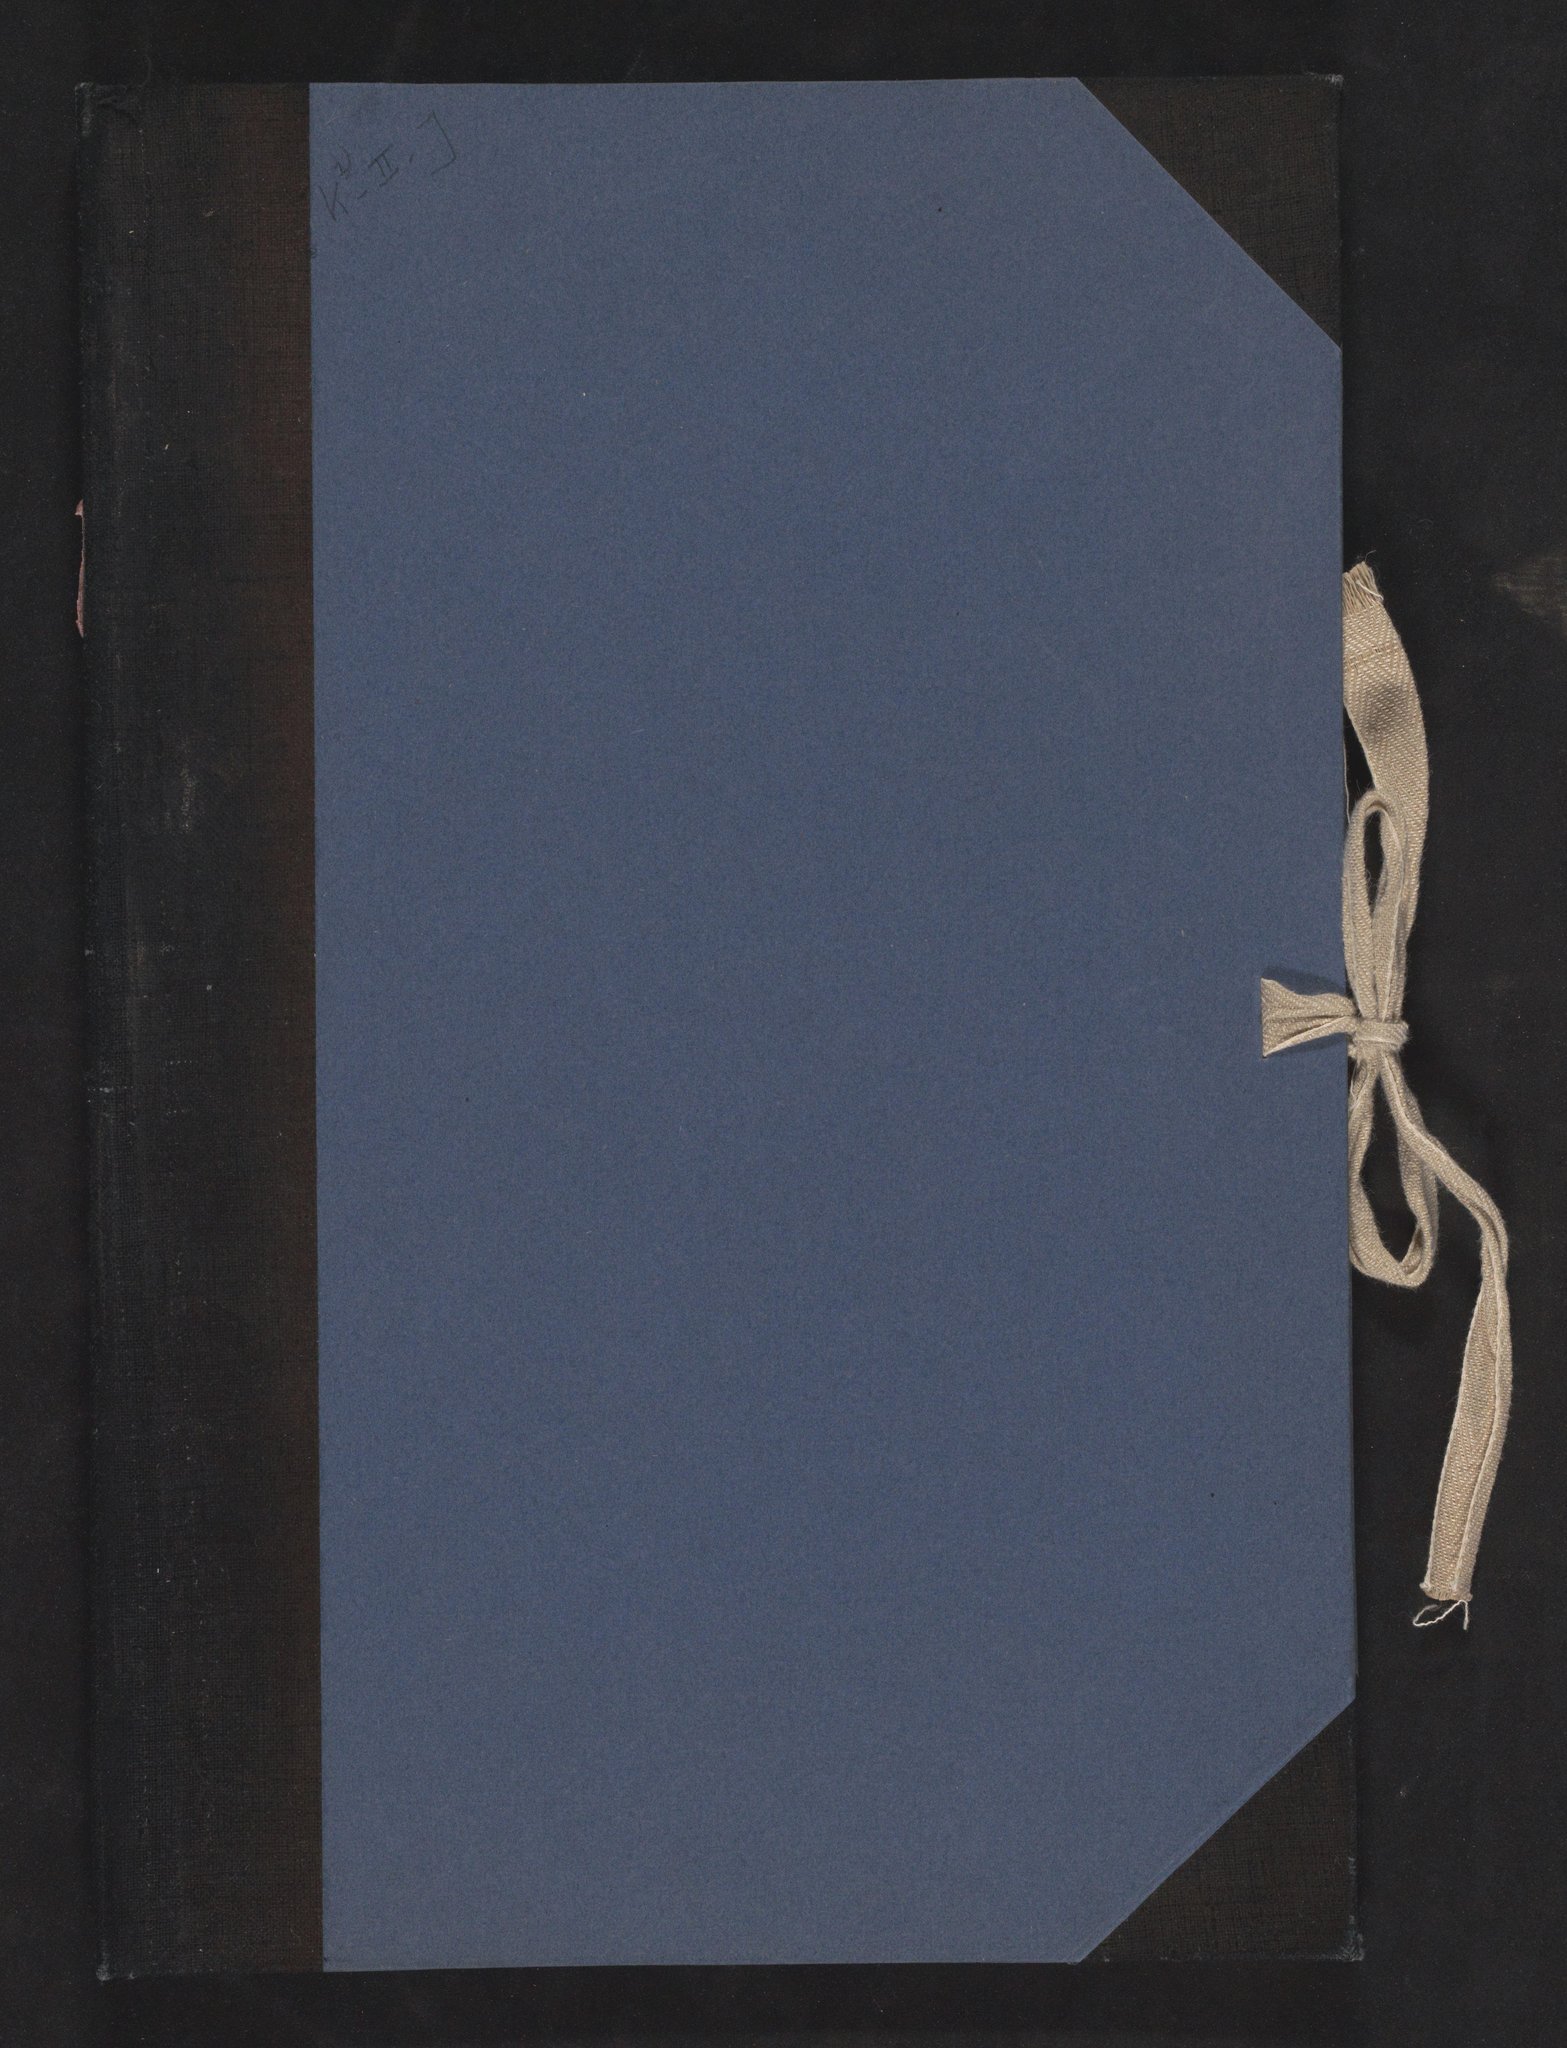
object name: sketchbook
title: Schetsboek met 20 bladen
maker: johan r. kruyff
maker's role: draughtsman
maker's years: 1844-1923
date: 1865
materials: cardboard, ink, linen, paper, pencil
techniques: pen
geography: amsterdam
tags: gate, entrance, façade (of house or building), plan ~ architecture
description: De volgende bladen uit het schetsboek zijn blanco: 1 t/m 4, 5(R), 6(V), 7(V), 8(V), 10(V), 11, 12, 13(R), 14(V) en 15 t/m 20.